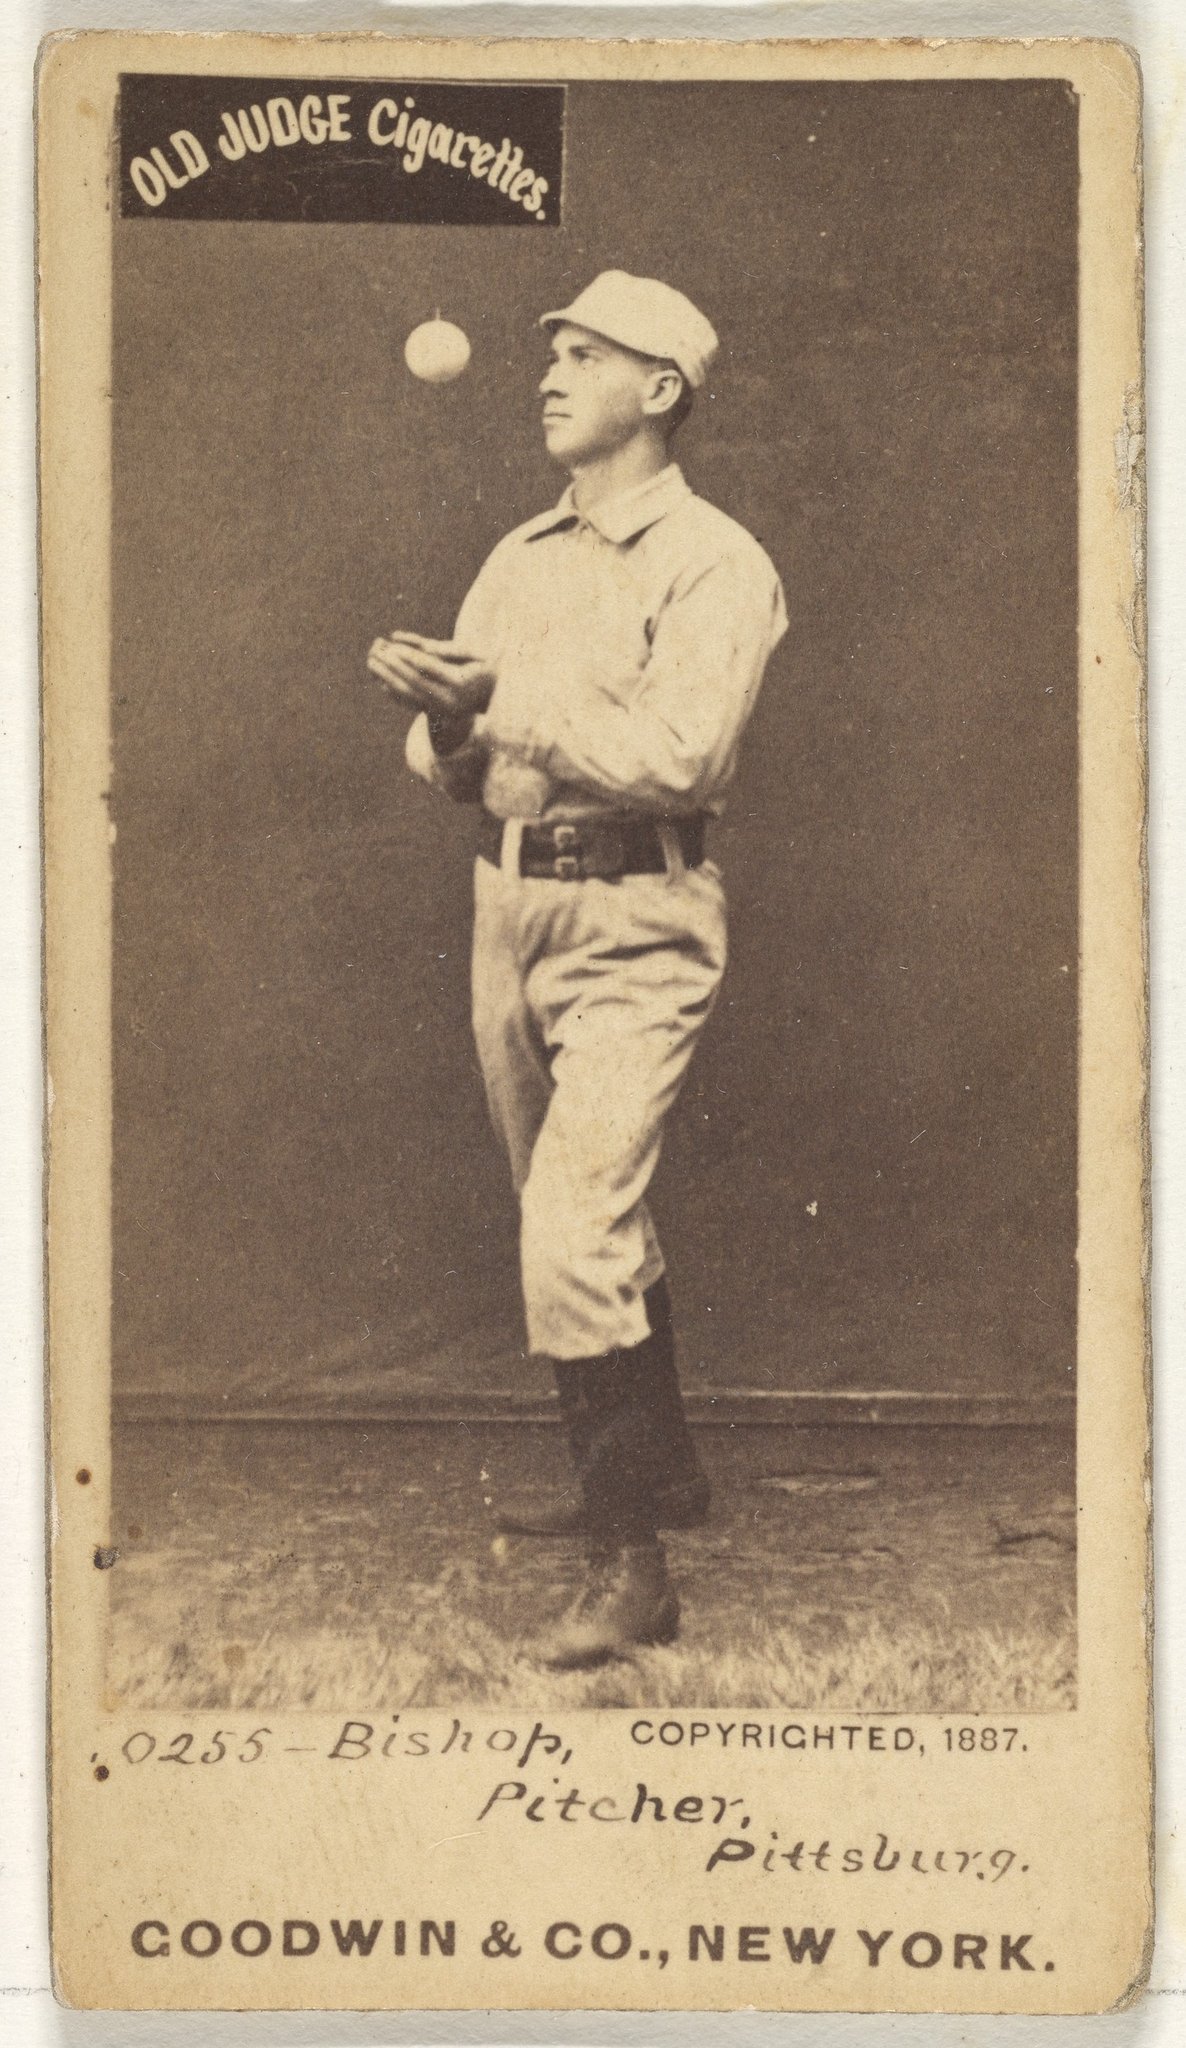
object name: baseball card, photograph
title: William "Bill" Robinson Bishop, Pitcher, Pittsburgh, from the Old Judge series (N172) for Old Judge Cigarettes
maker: goodwin & company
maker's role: publisher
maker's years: 1850-1950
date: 1887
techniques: albumen silver print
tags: men,portraits,baseball,athletes